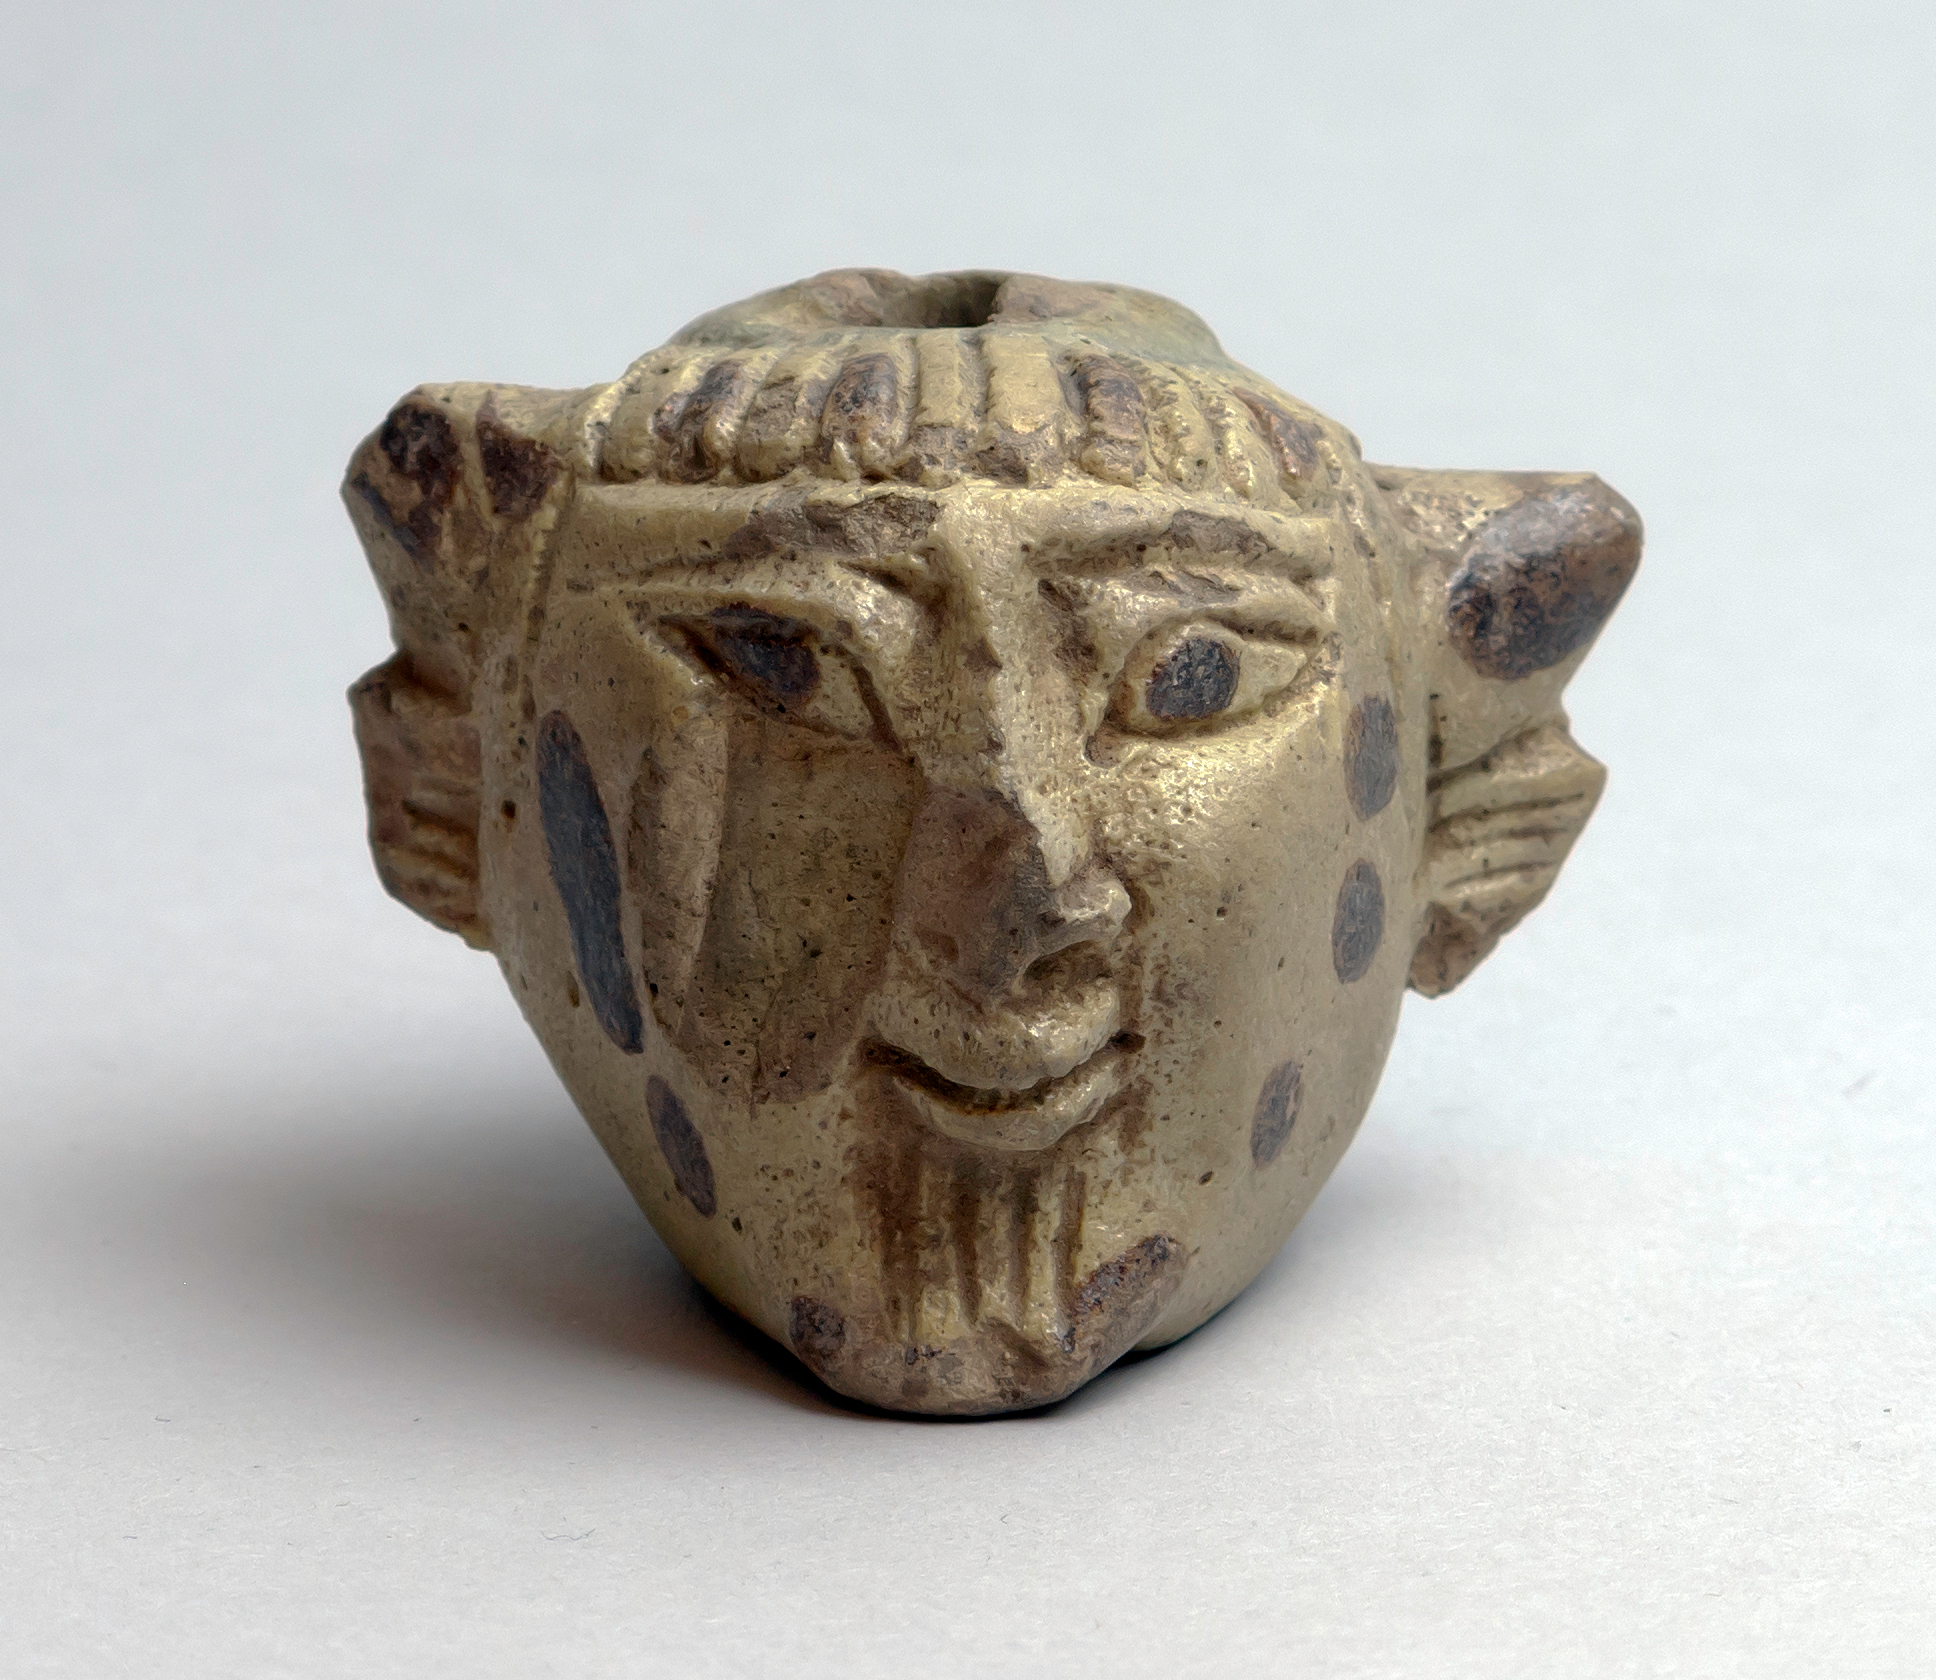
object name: aryballos in the form of a head of acheloös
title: Faience aryballos (perfume vase) in the form of a head of Acheloös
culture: east greek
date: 600-501 BCE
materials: faience